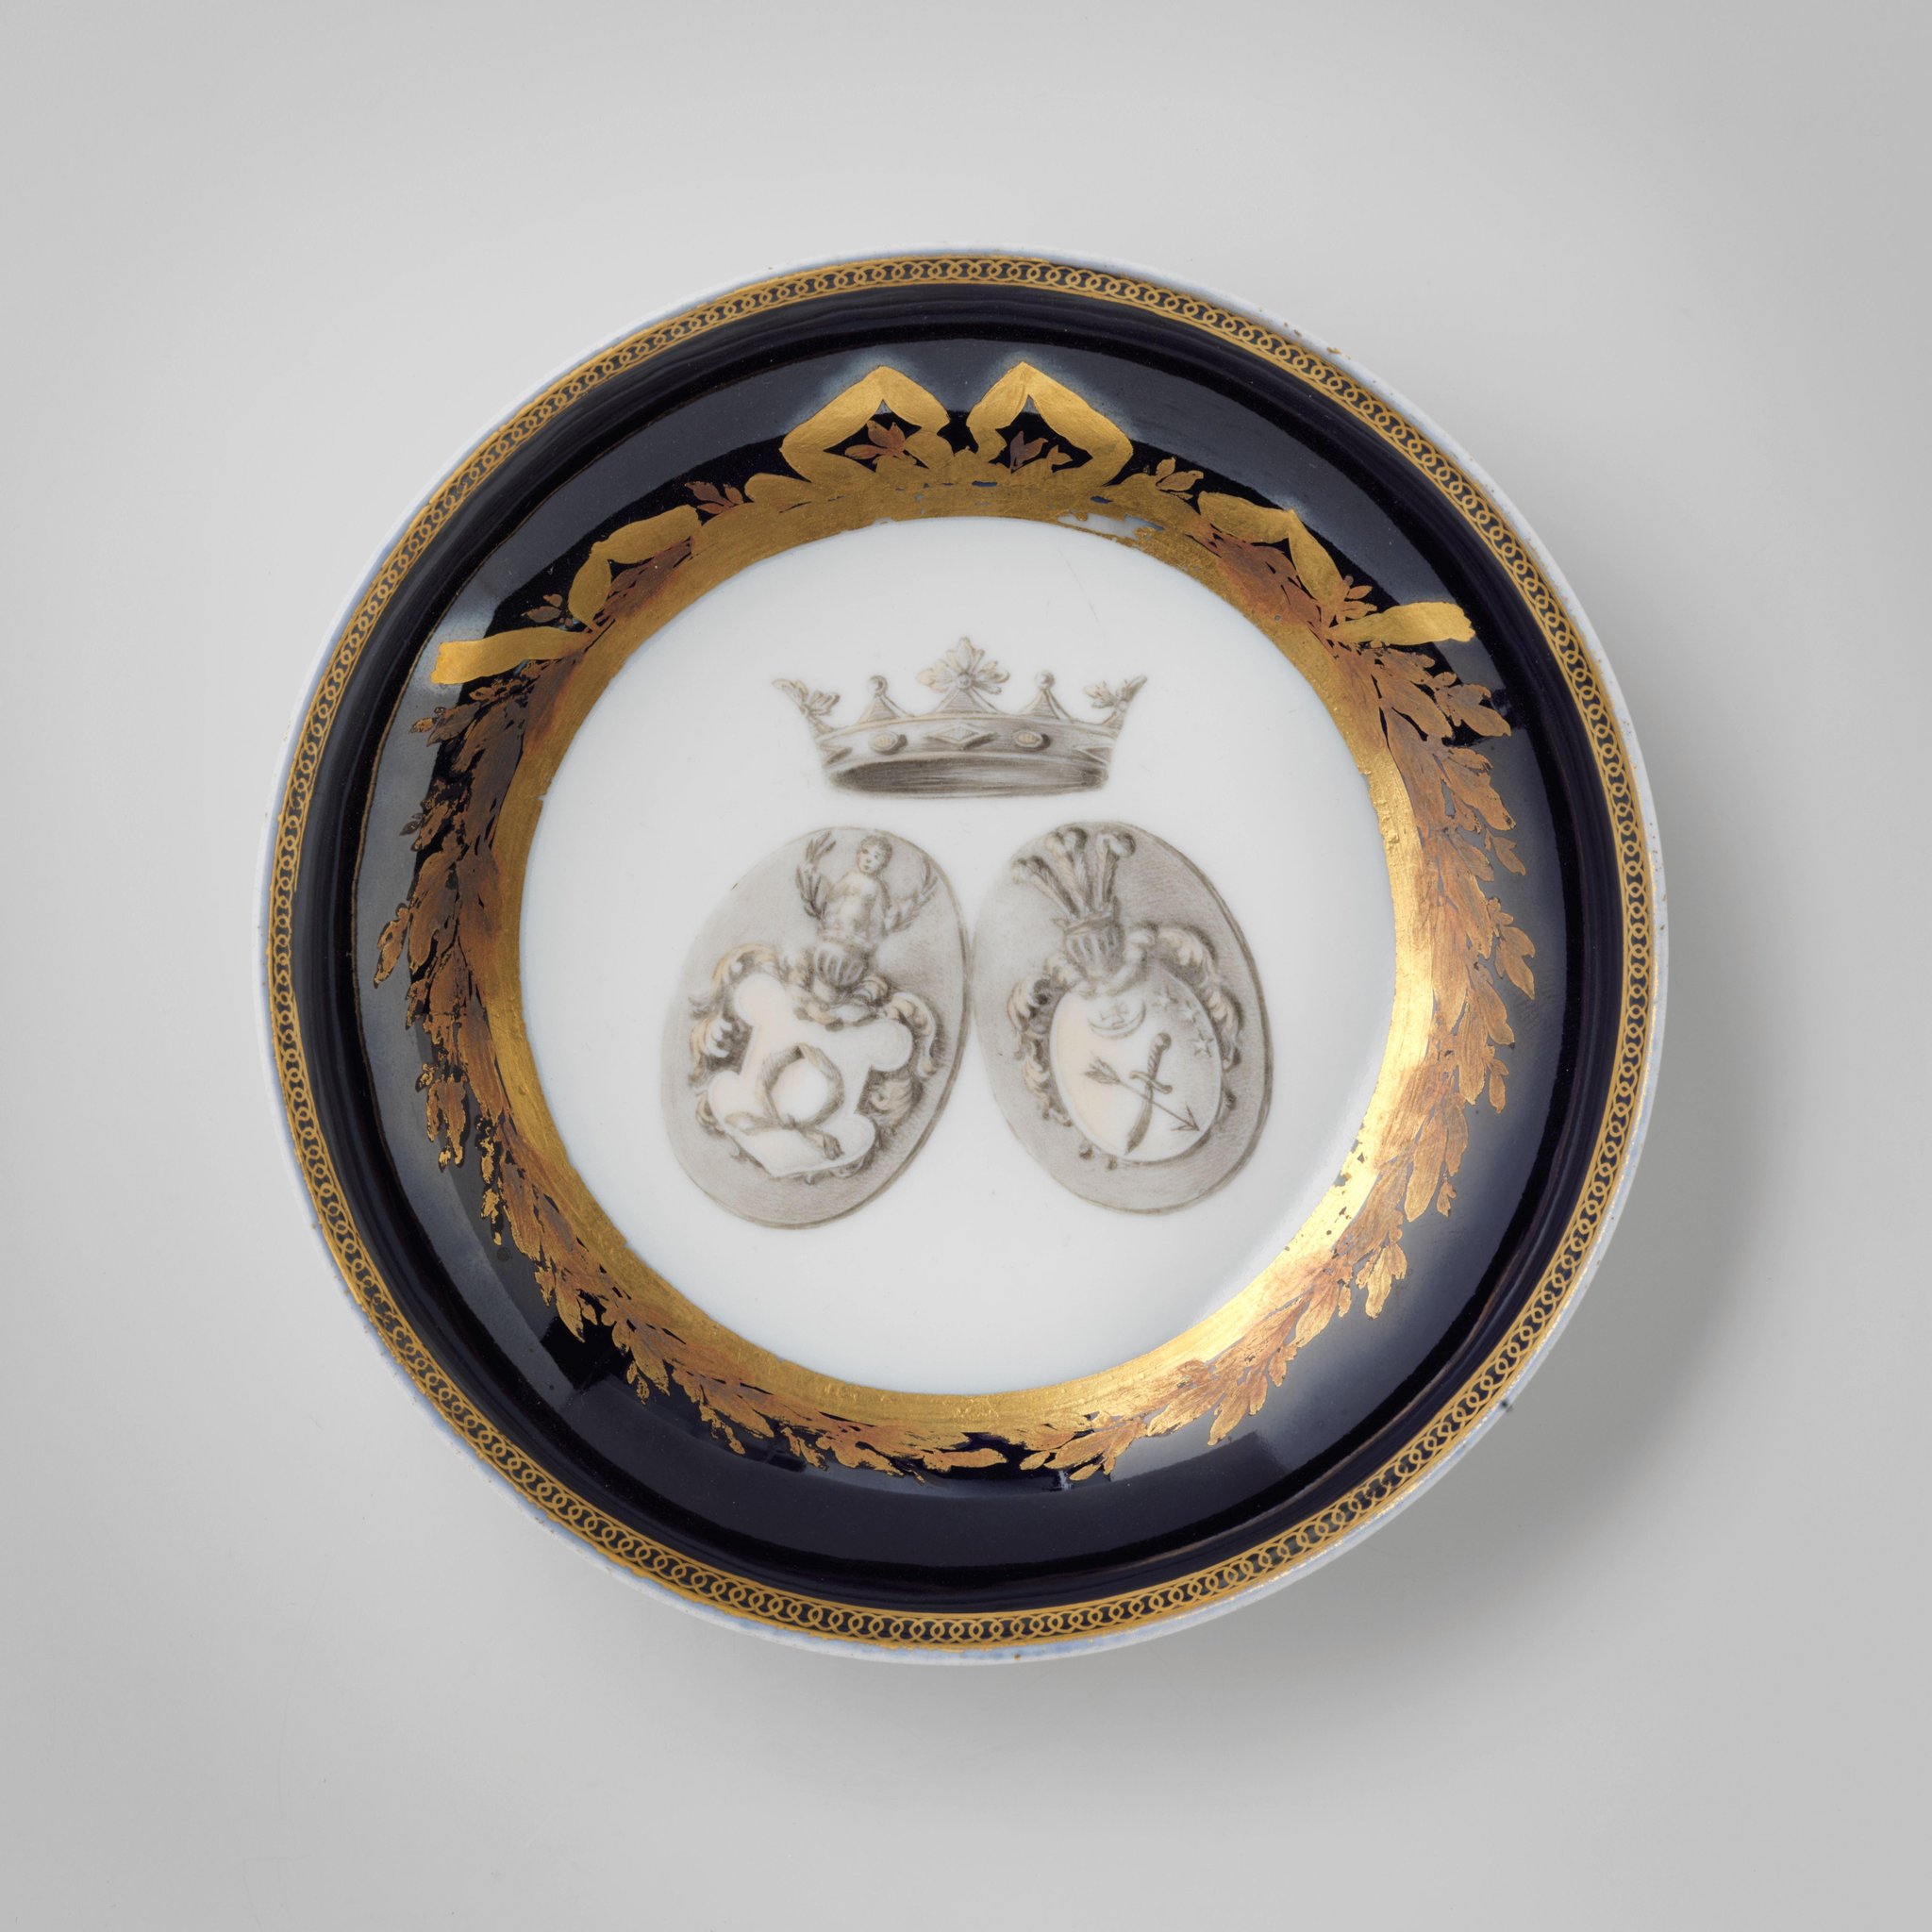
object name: platter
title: Schotel, beschilderd met een onbekend alliantiewapen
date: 1775-1780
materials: porcelain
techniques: painted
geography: meissen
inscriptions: factory mark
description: Cup and saucer with the arms of an unidentified family. Porcelain. Meissen, c. 1775 - 1780.